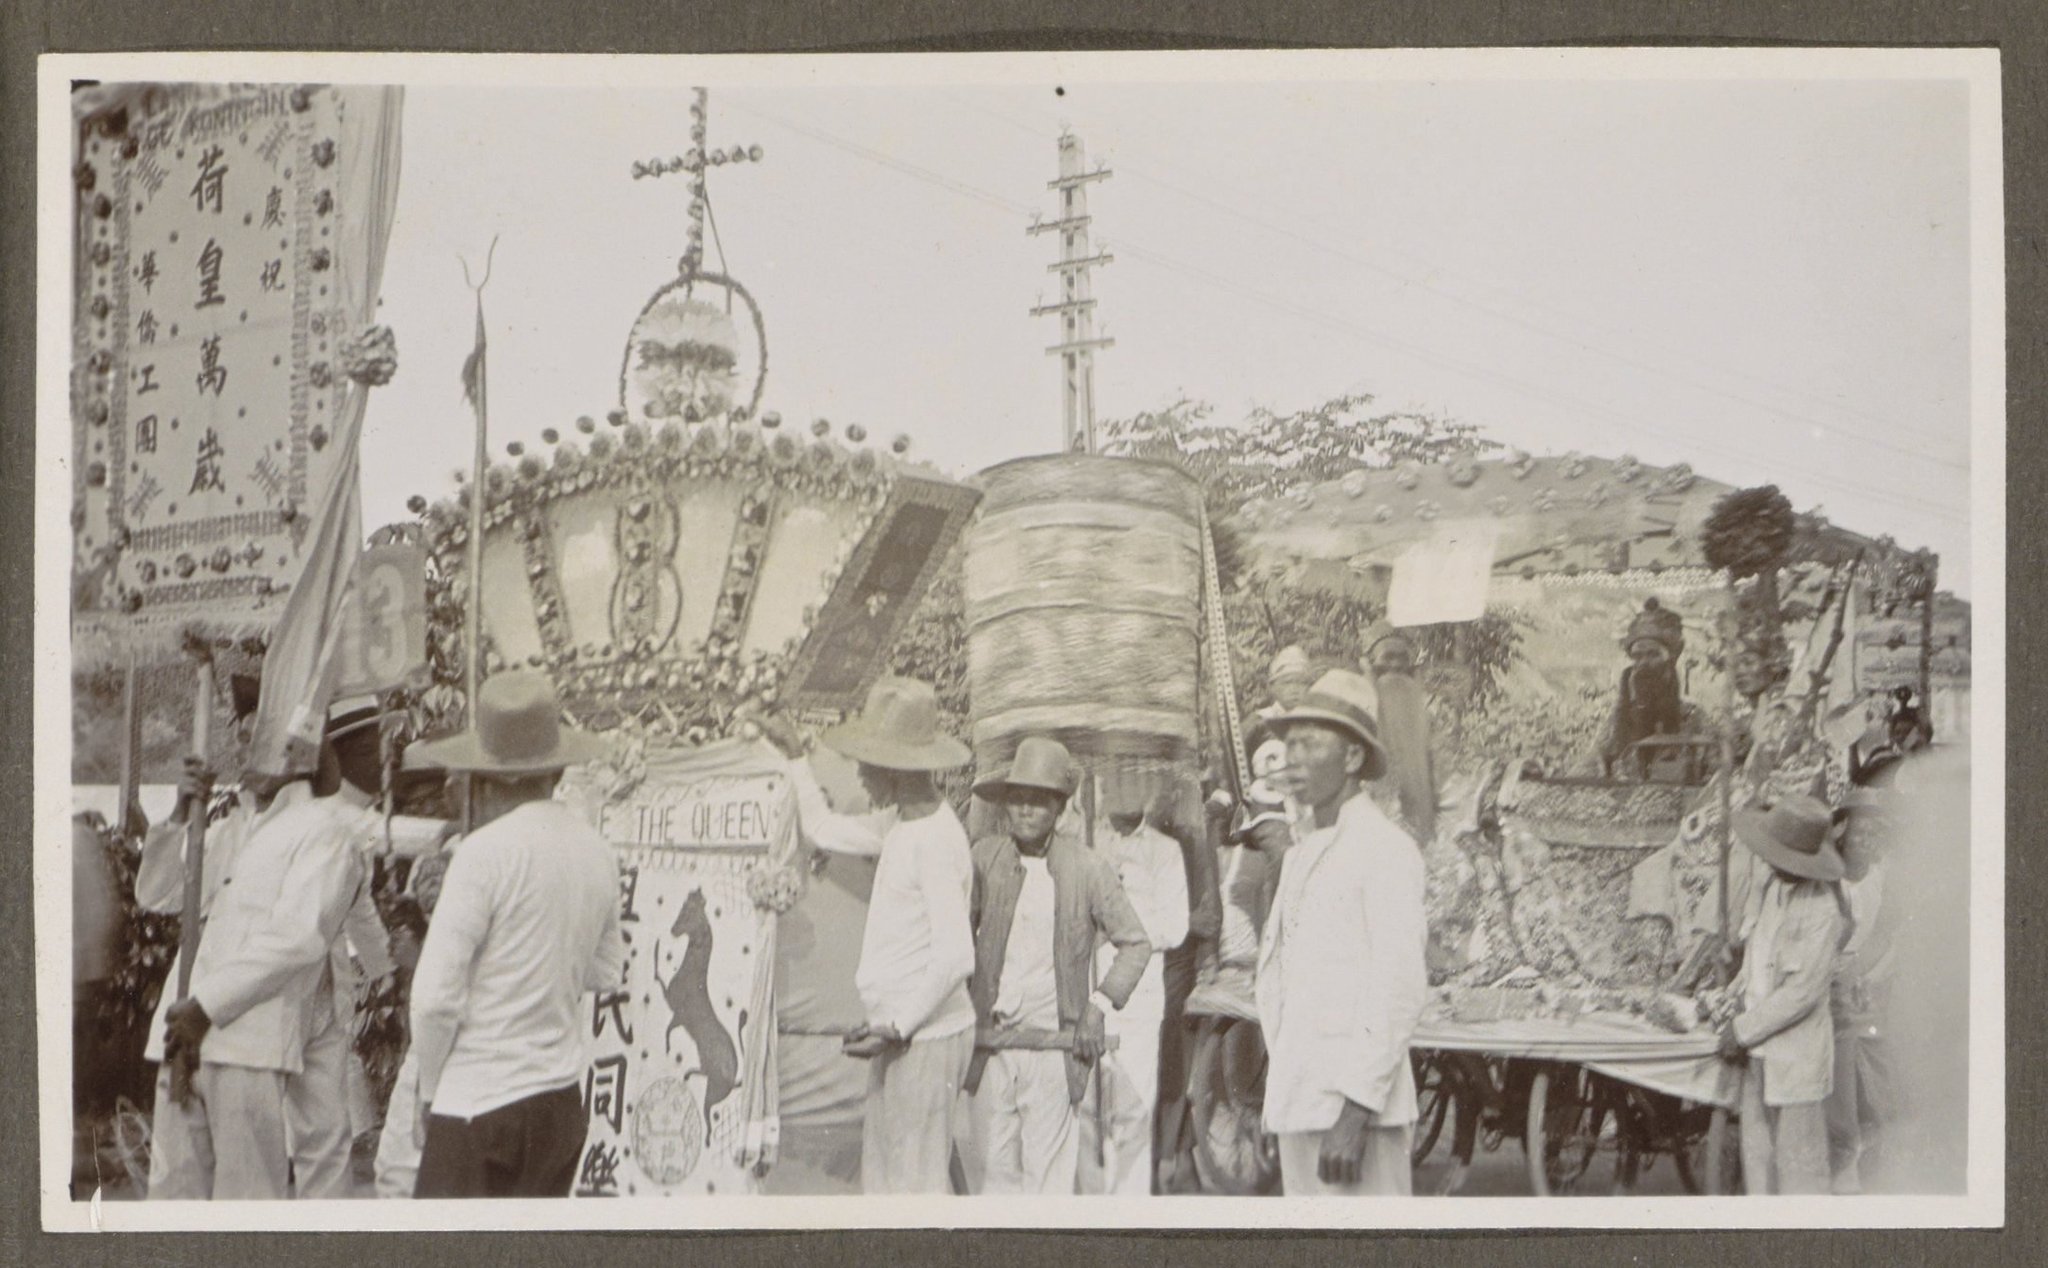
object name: photograph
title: Deelnemers aan een optocht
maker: Anonymous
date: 1920-1930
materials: photographic support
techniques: gelatin silver print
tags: public festivities at birth of royal persons, dutch east indies, the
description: Mannen met hoeden dragen een uitvergrote kroon met een rijksappel mee. Daaronder een wapenbord met een gekroond paard met een zwaard en Chinese tekens. Deels zichtbaar is de tekst "..E THE QUEEN". Links een vaandel met Chinese tekens. Onderdeel van familiealbum Nederlands-Indië.